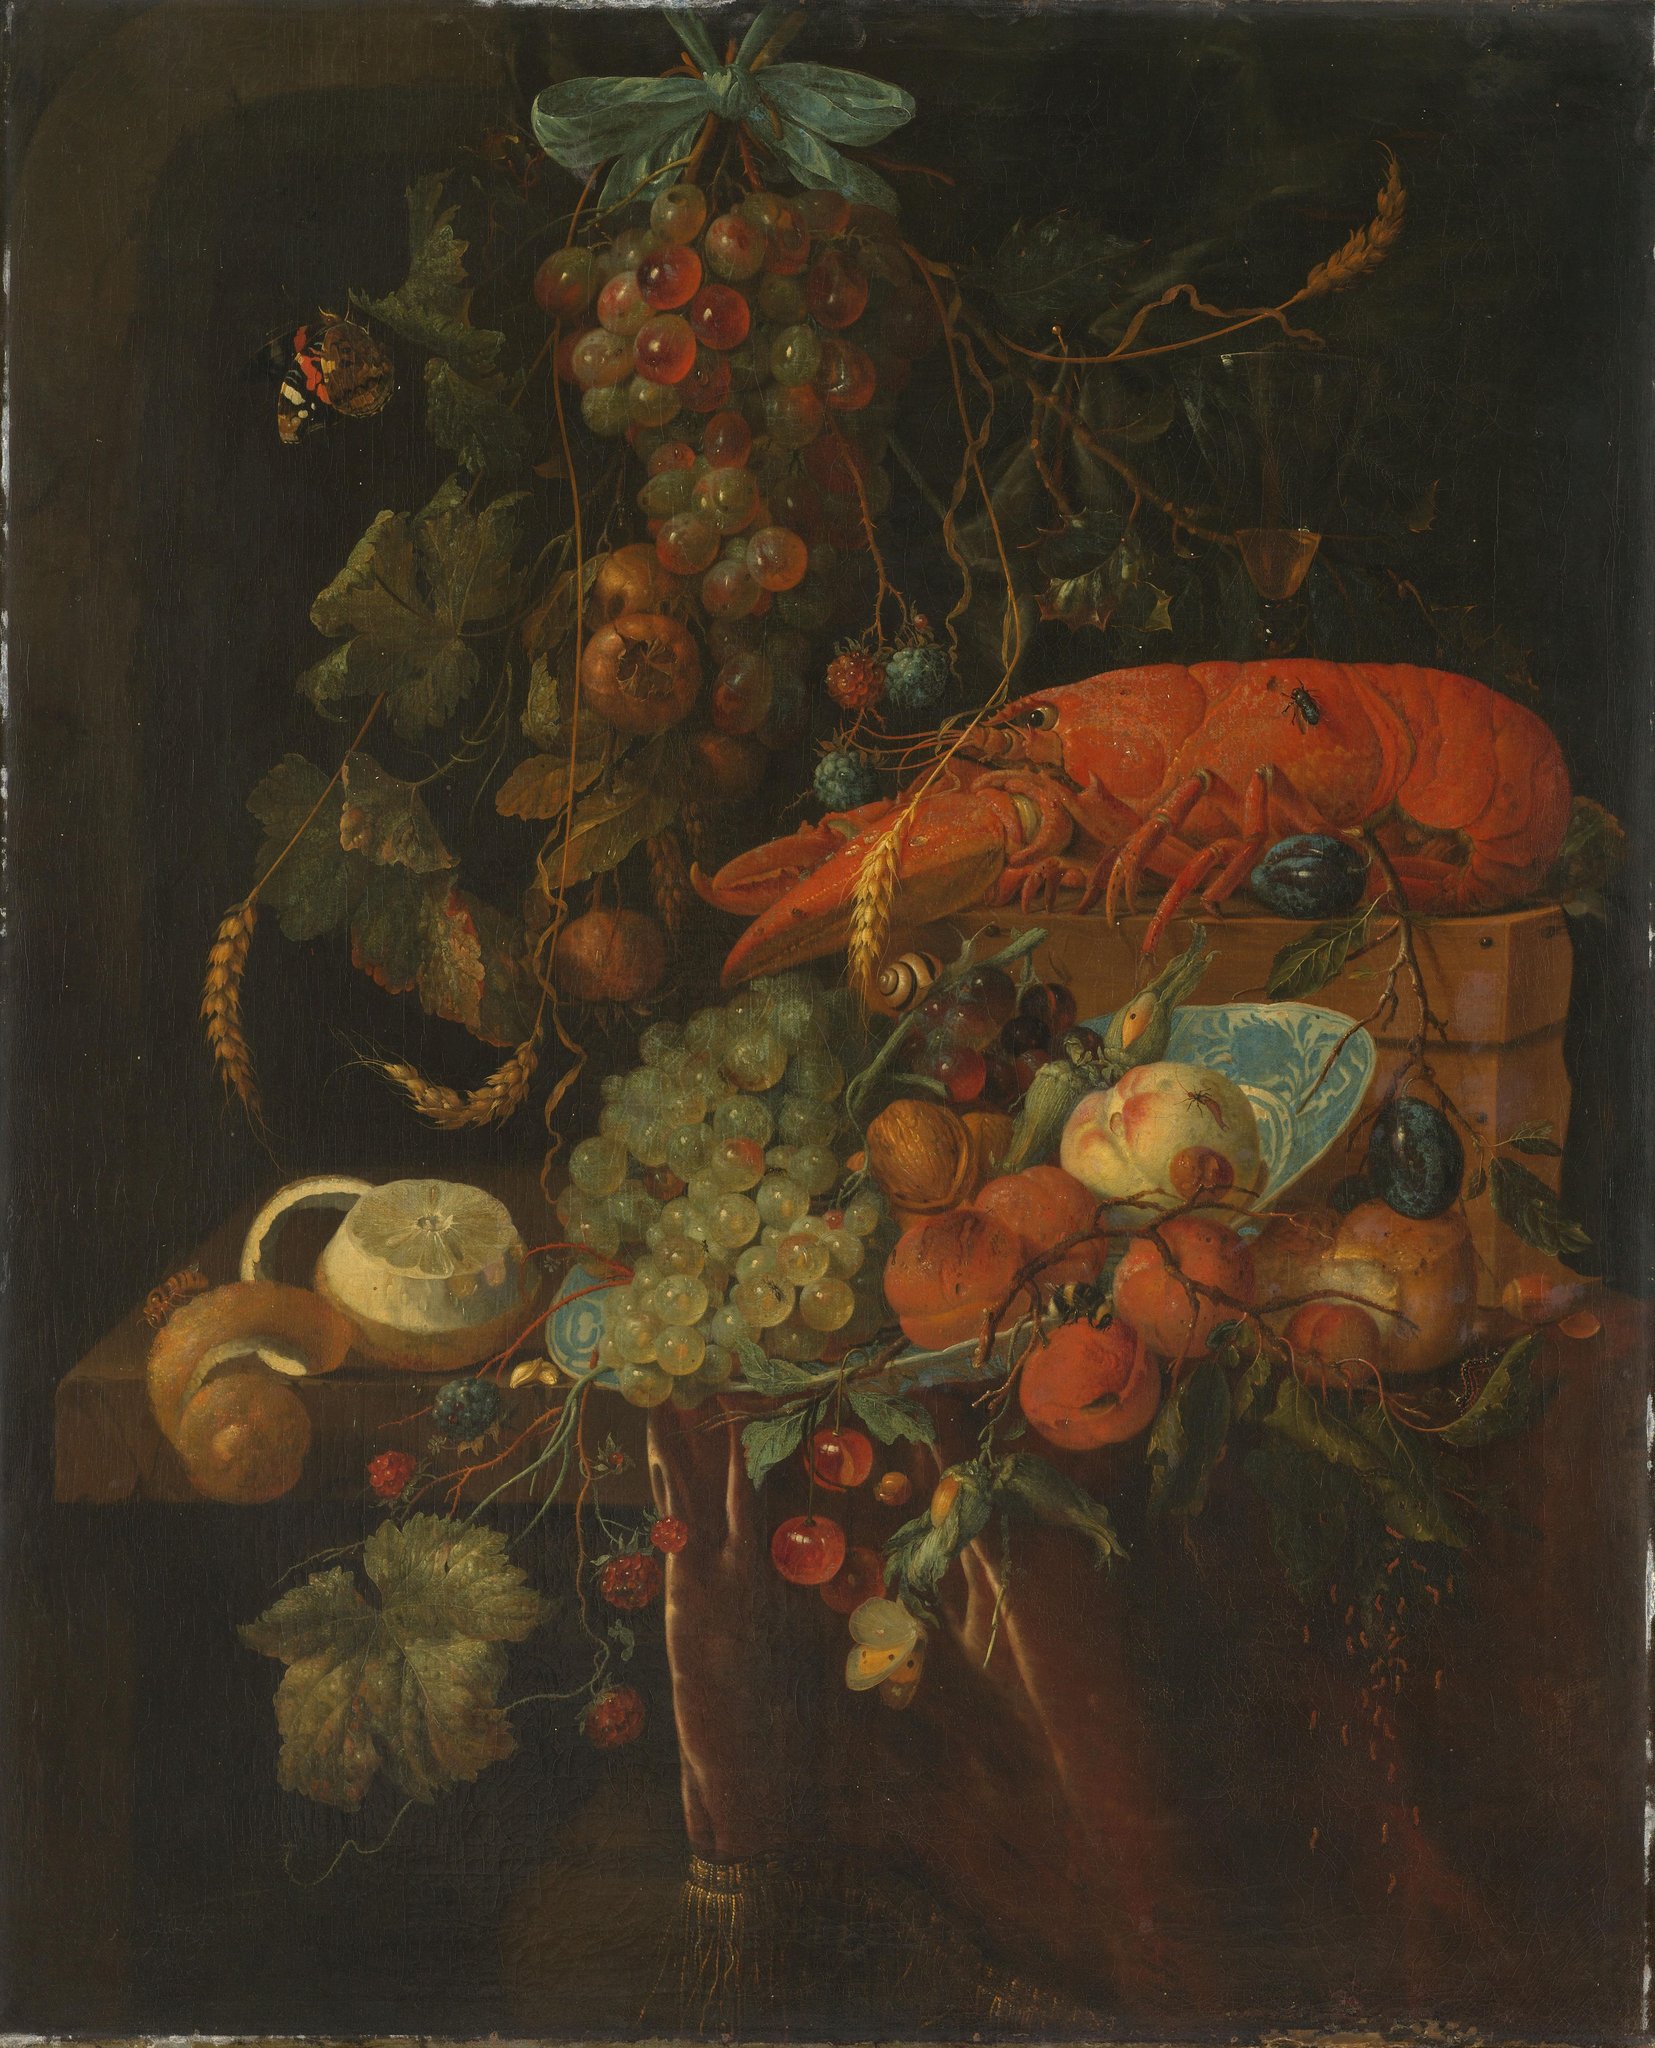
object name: painting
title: Still Life with Fruit and a Lobster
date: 1640-1700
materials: canvas, oil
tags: fruit, crustaceans: lobster, foodstuffs; still life of foodstuffs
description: Stilleven met vruchten en een kreeft. Aan de muur hangt een festoen van vruchten. Op tafel een Chinees bord met druiven, perzik en abrikozen. Links een geschilde citroen. Tussen de vruchten allerlei insecten en slakken. Oude kopie naar het origineel in Dresden.